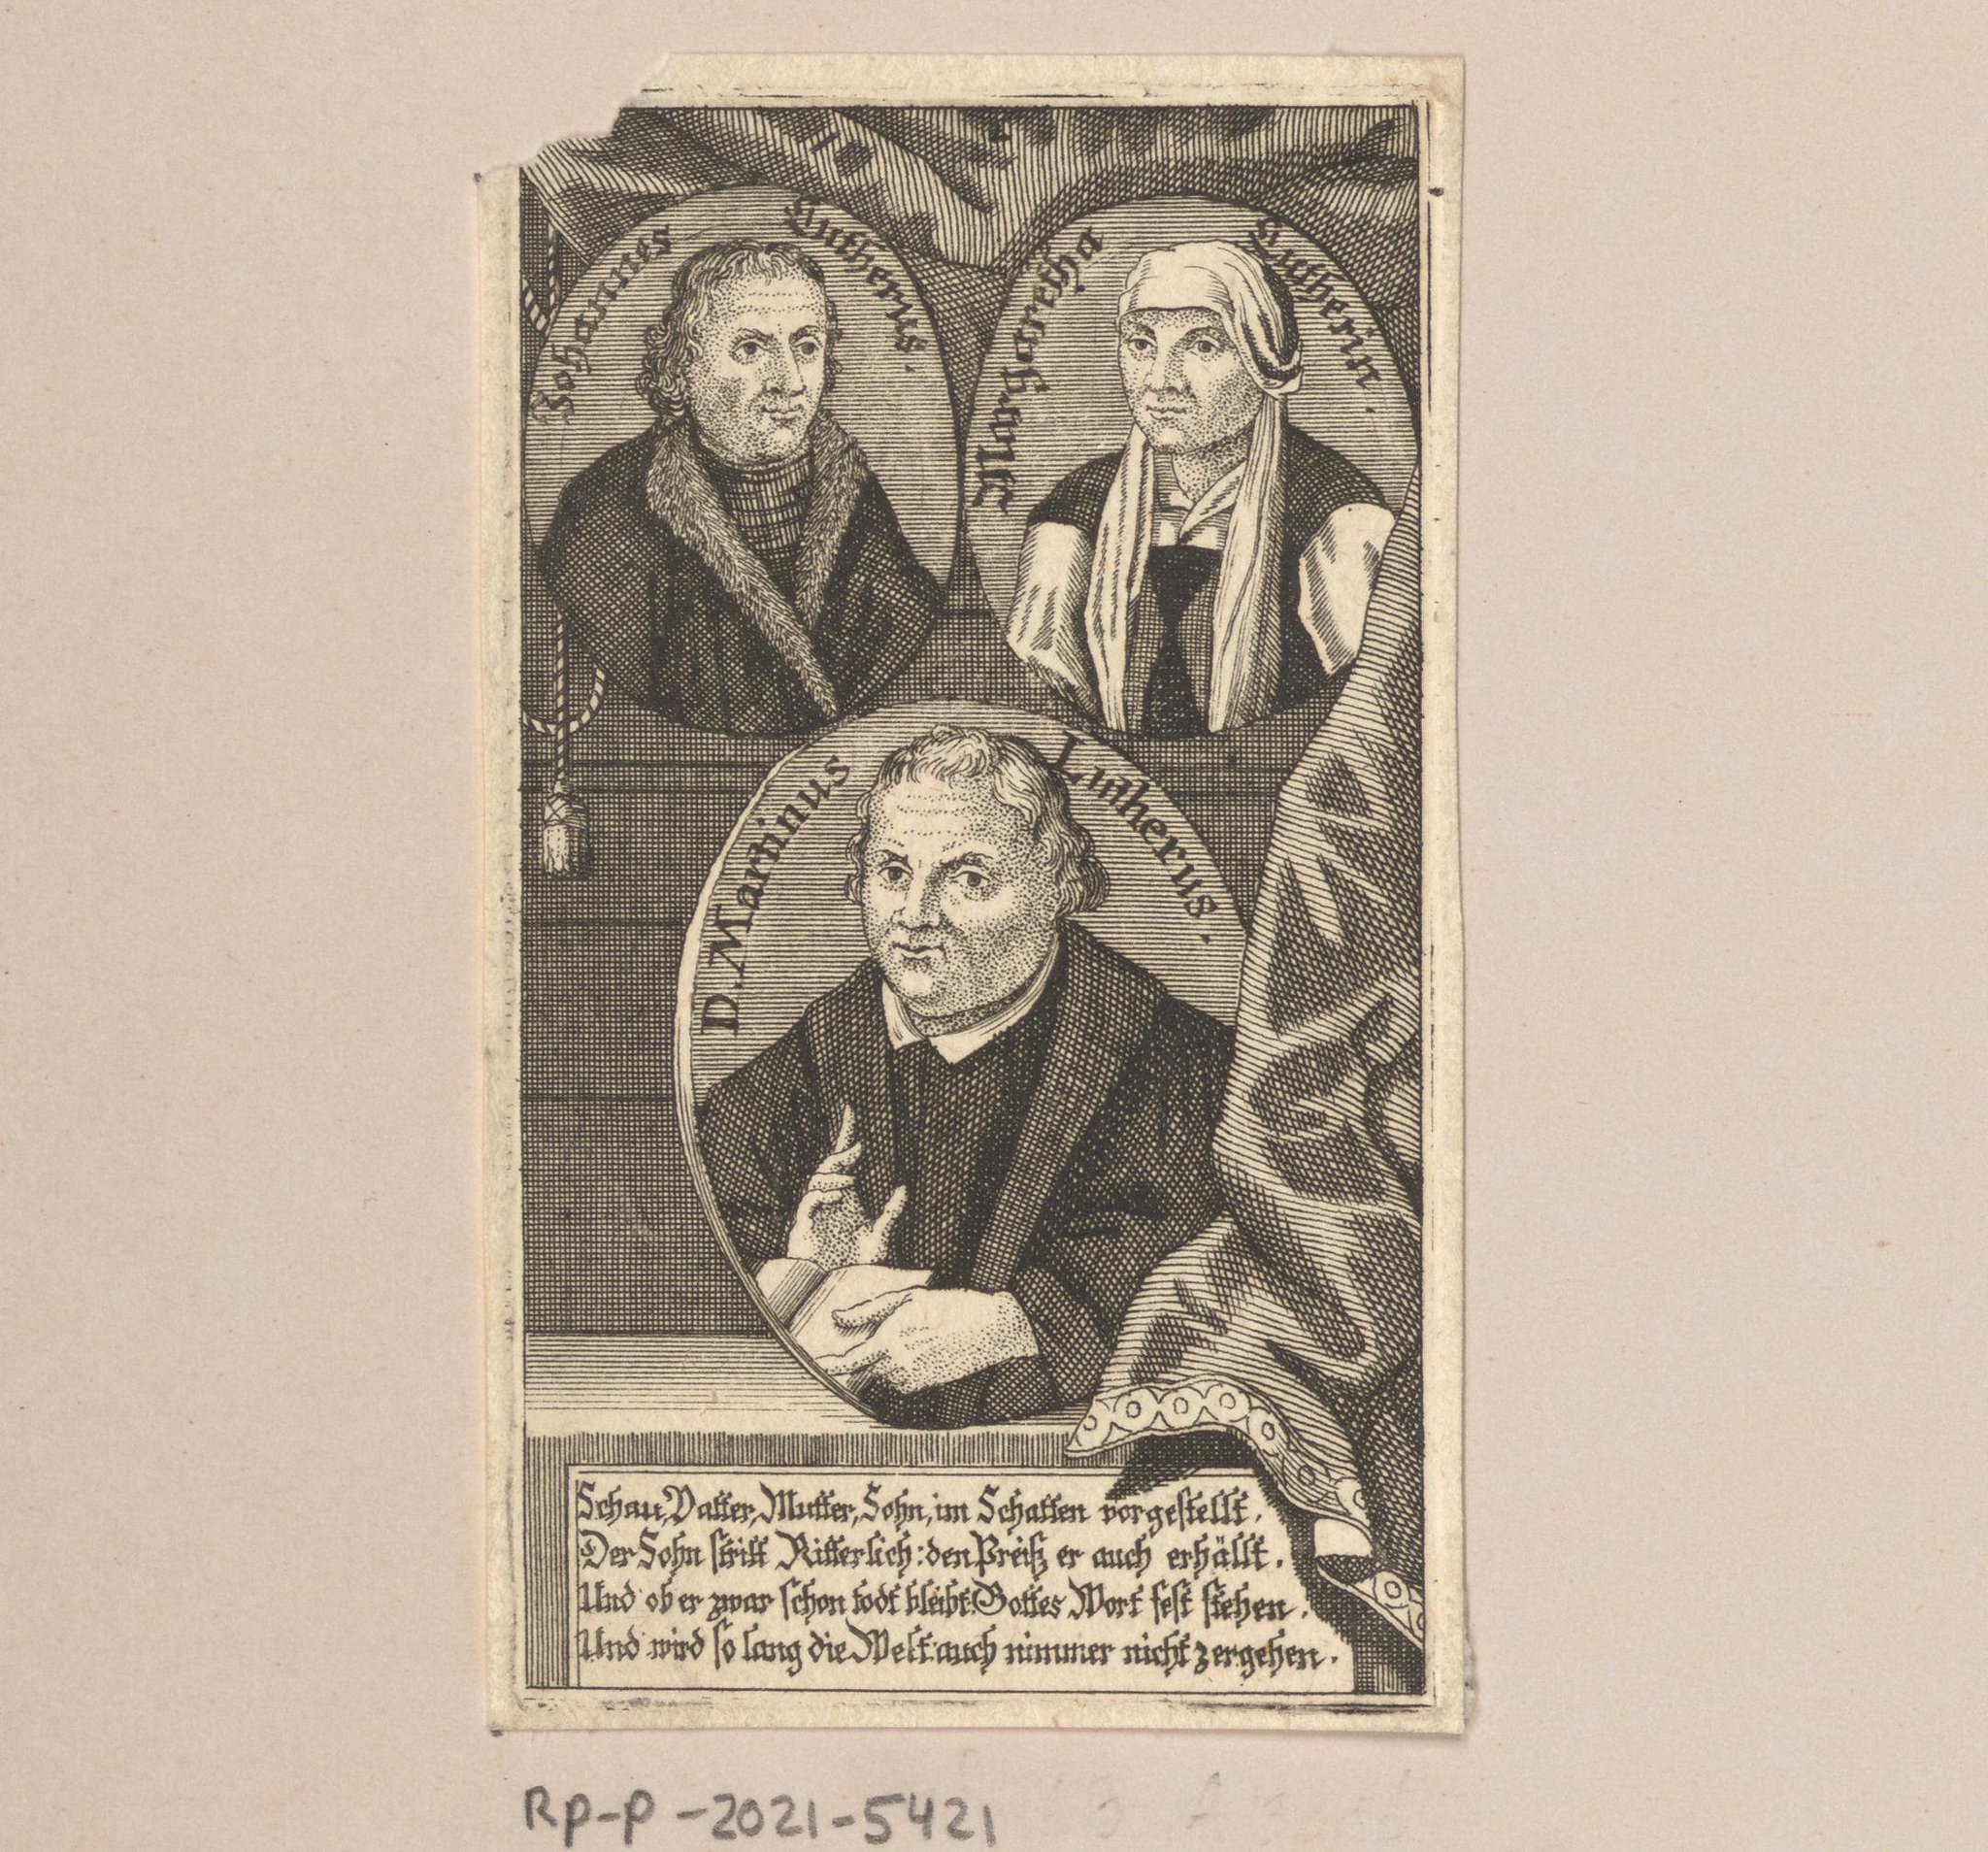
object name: print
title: Drie portretten van Hans, Margarethe en Martin Luther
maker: Anonymous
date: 1700-1799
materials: paper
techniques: engraving, etching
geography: germany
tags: priest, martin luther, parents with their children, theologian, historical persons - bb - woman, ornament ~ medallion, historical persons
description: Met vierregelig onderschrift in het Duits.